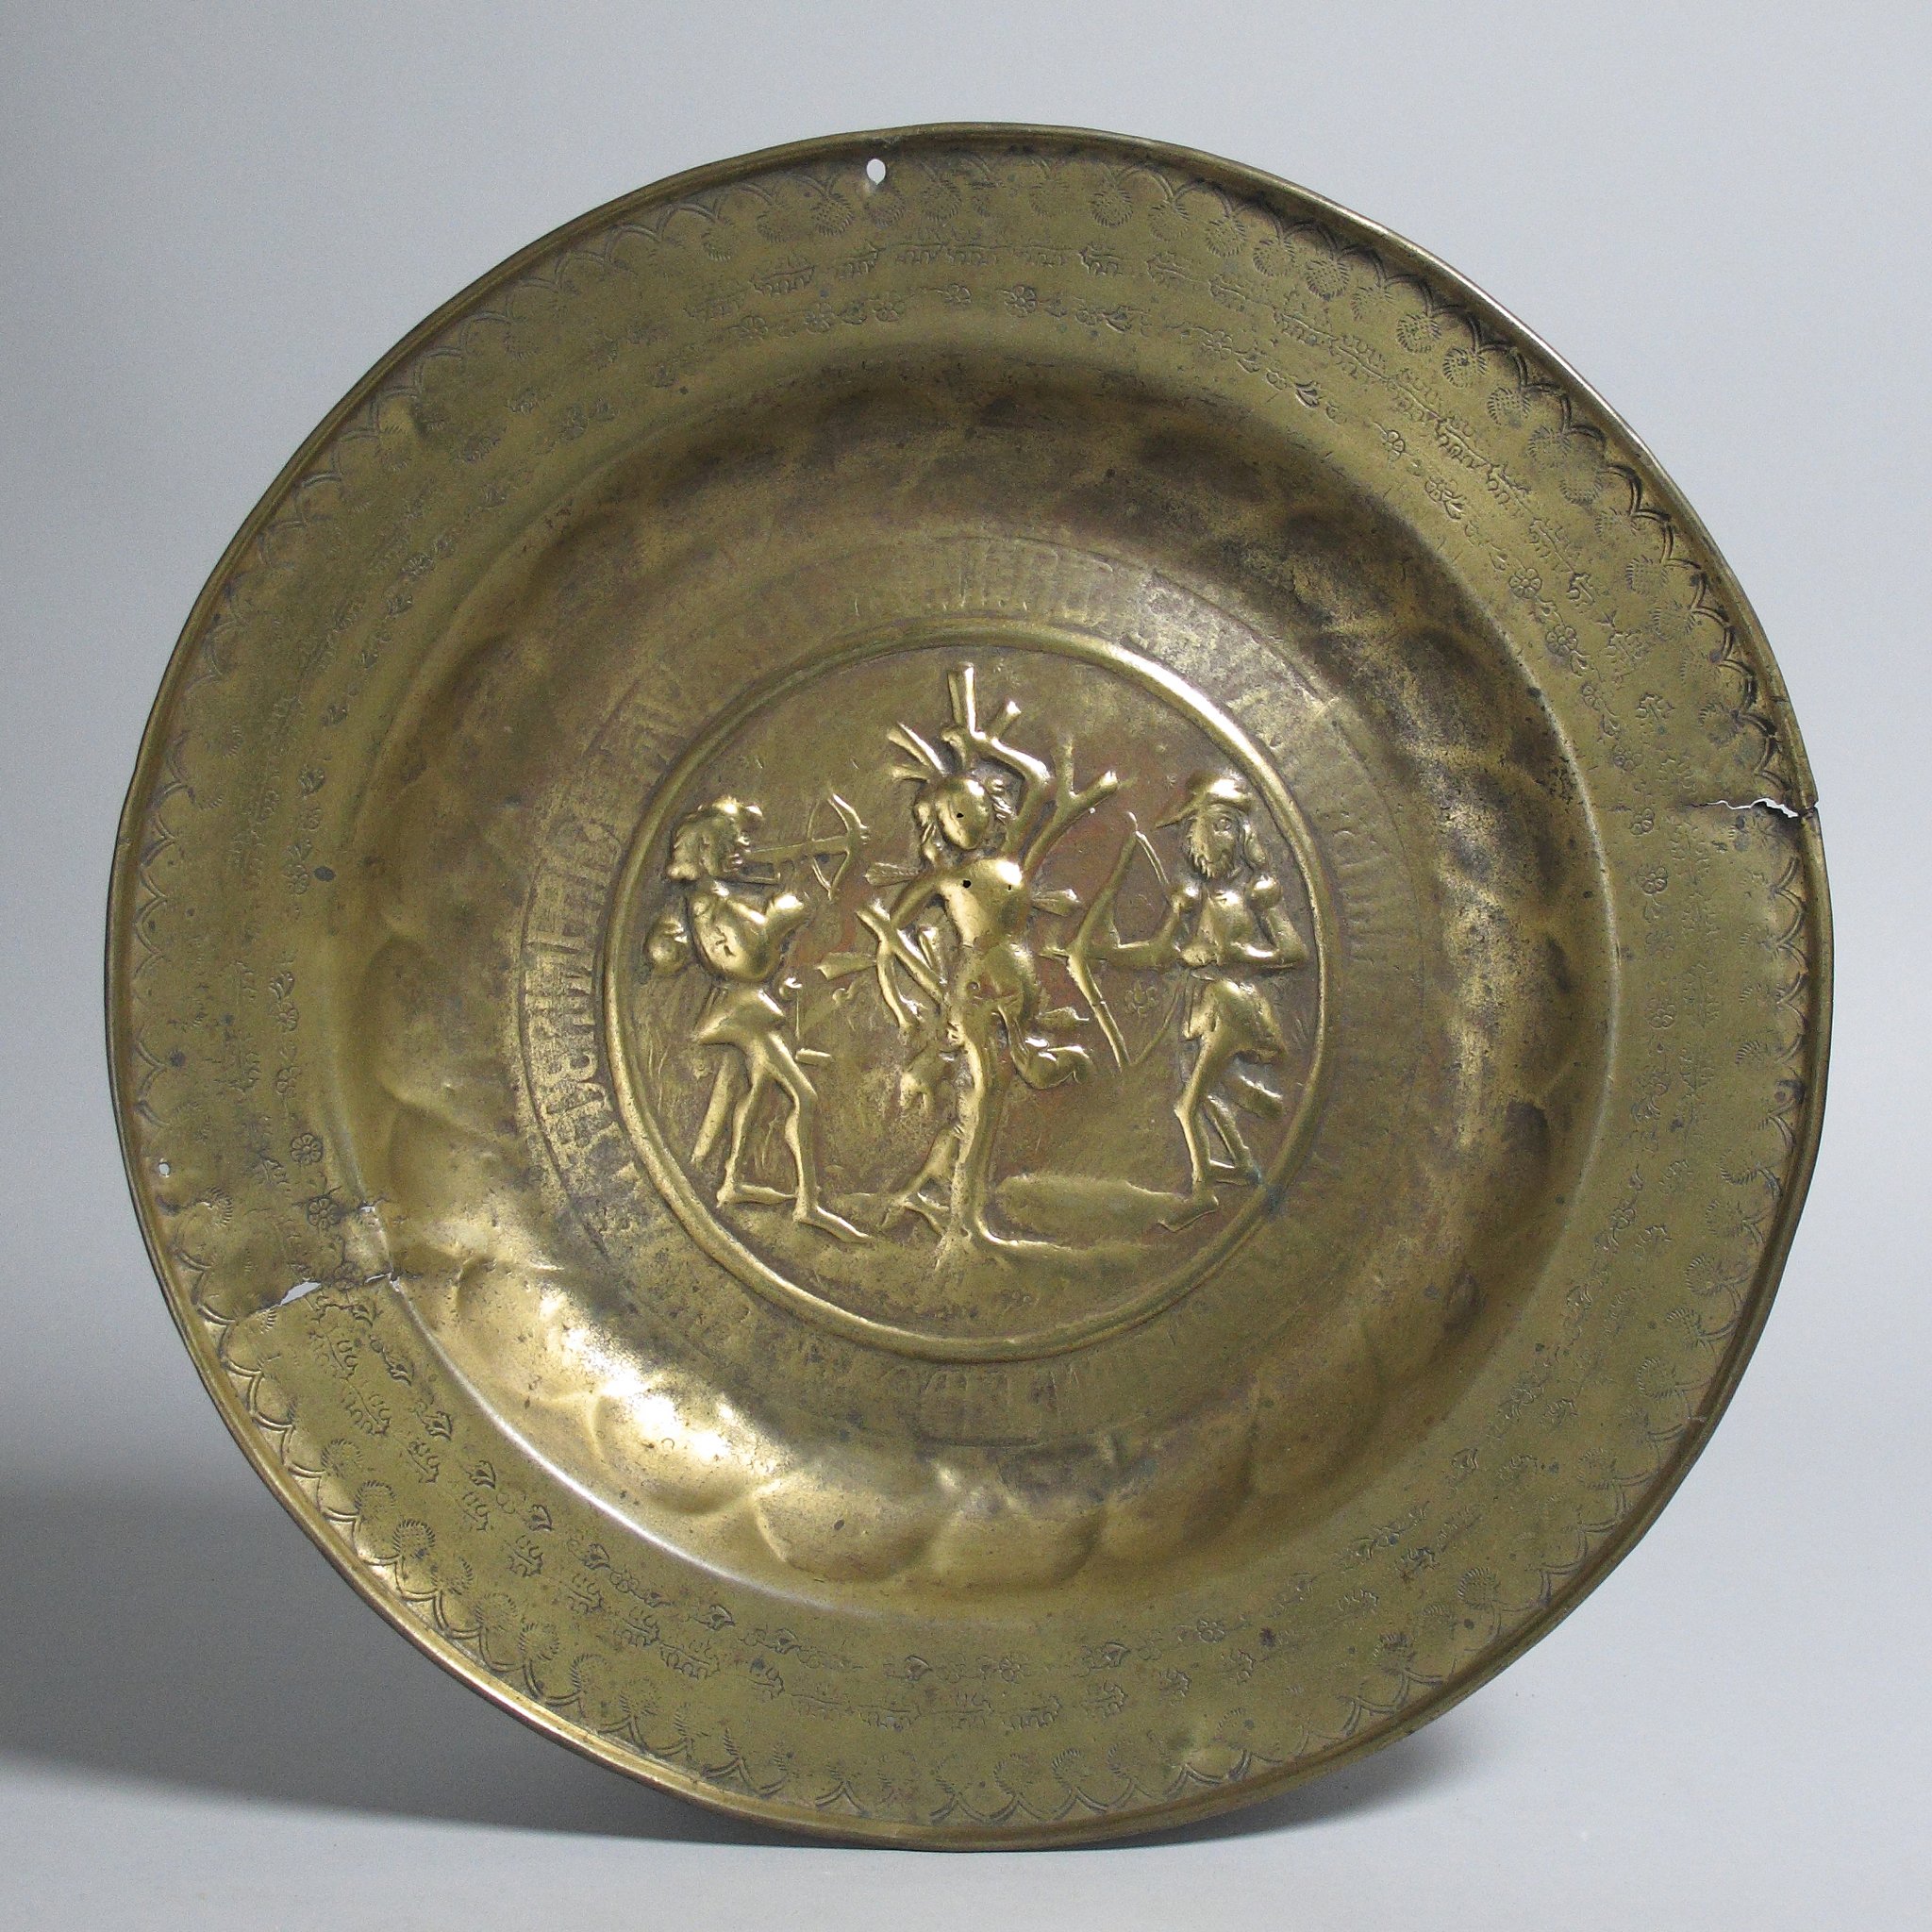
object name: dish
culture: german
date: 1501-1533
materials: brass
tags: human figures,bow and arrow